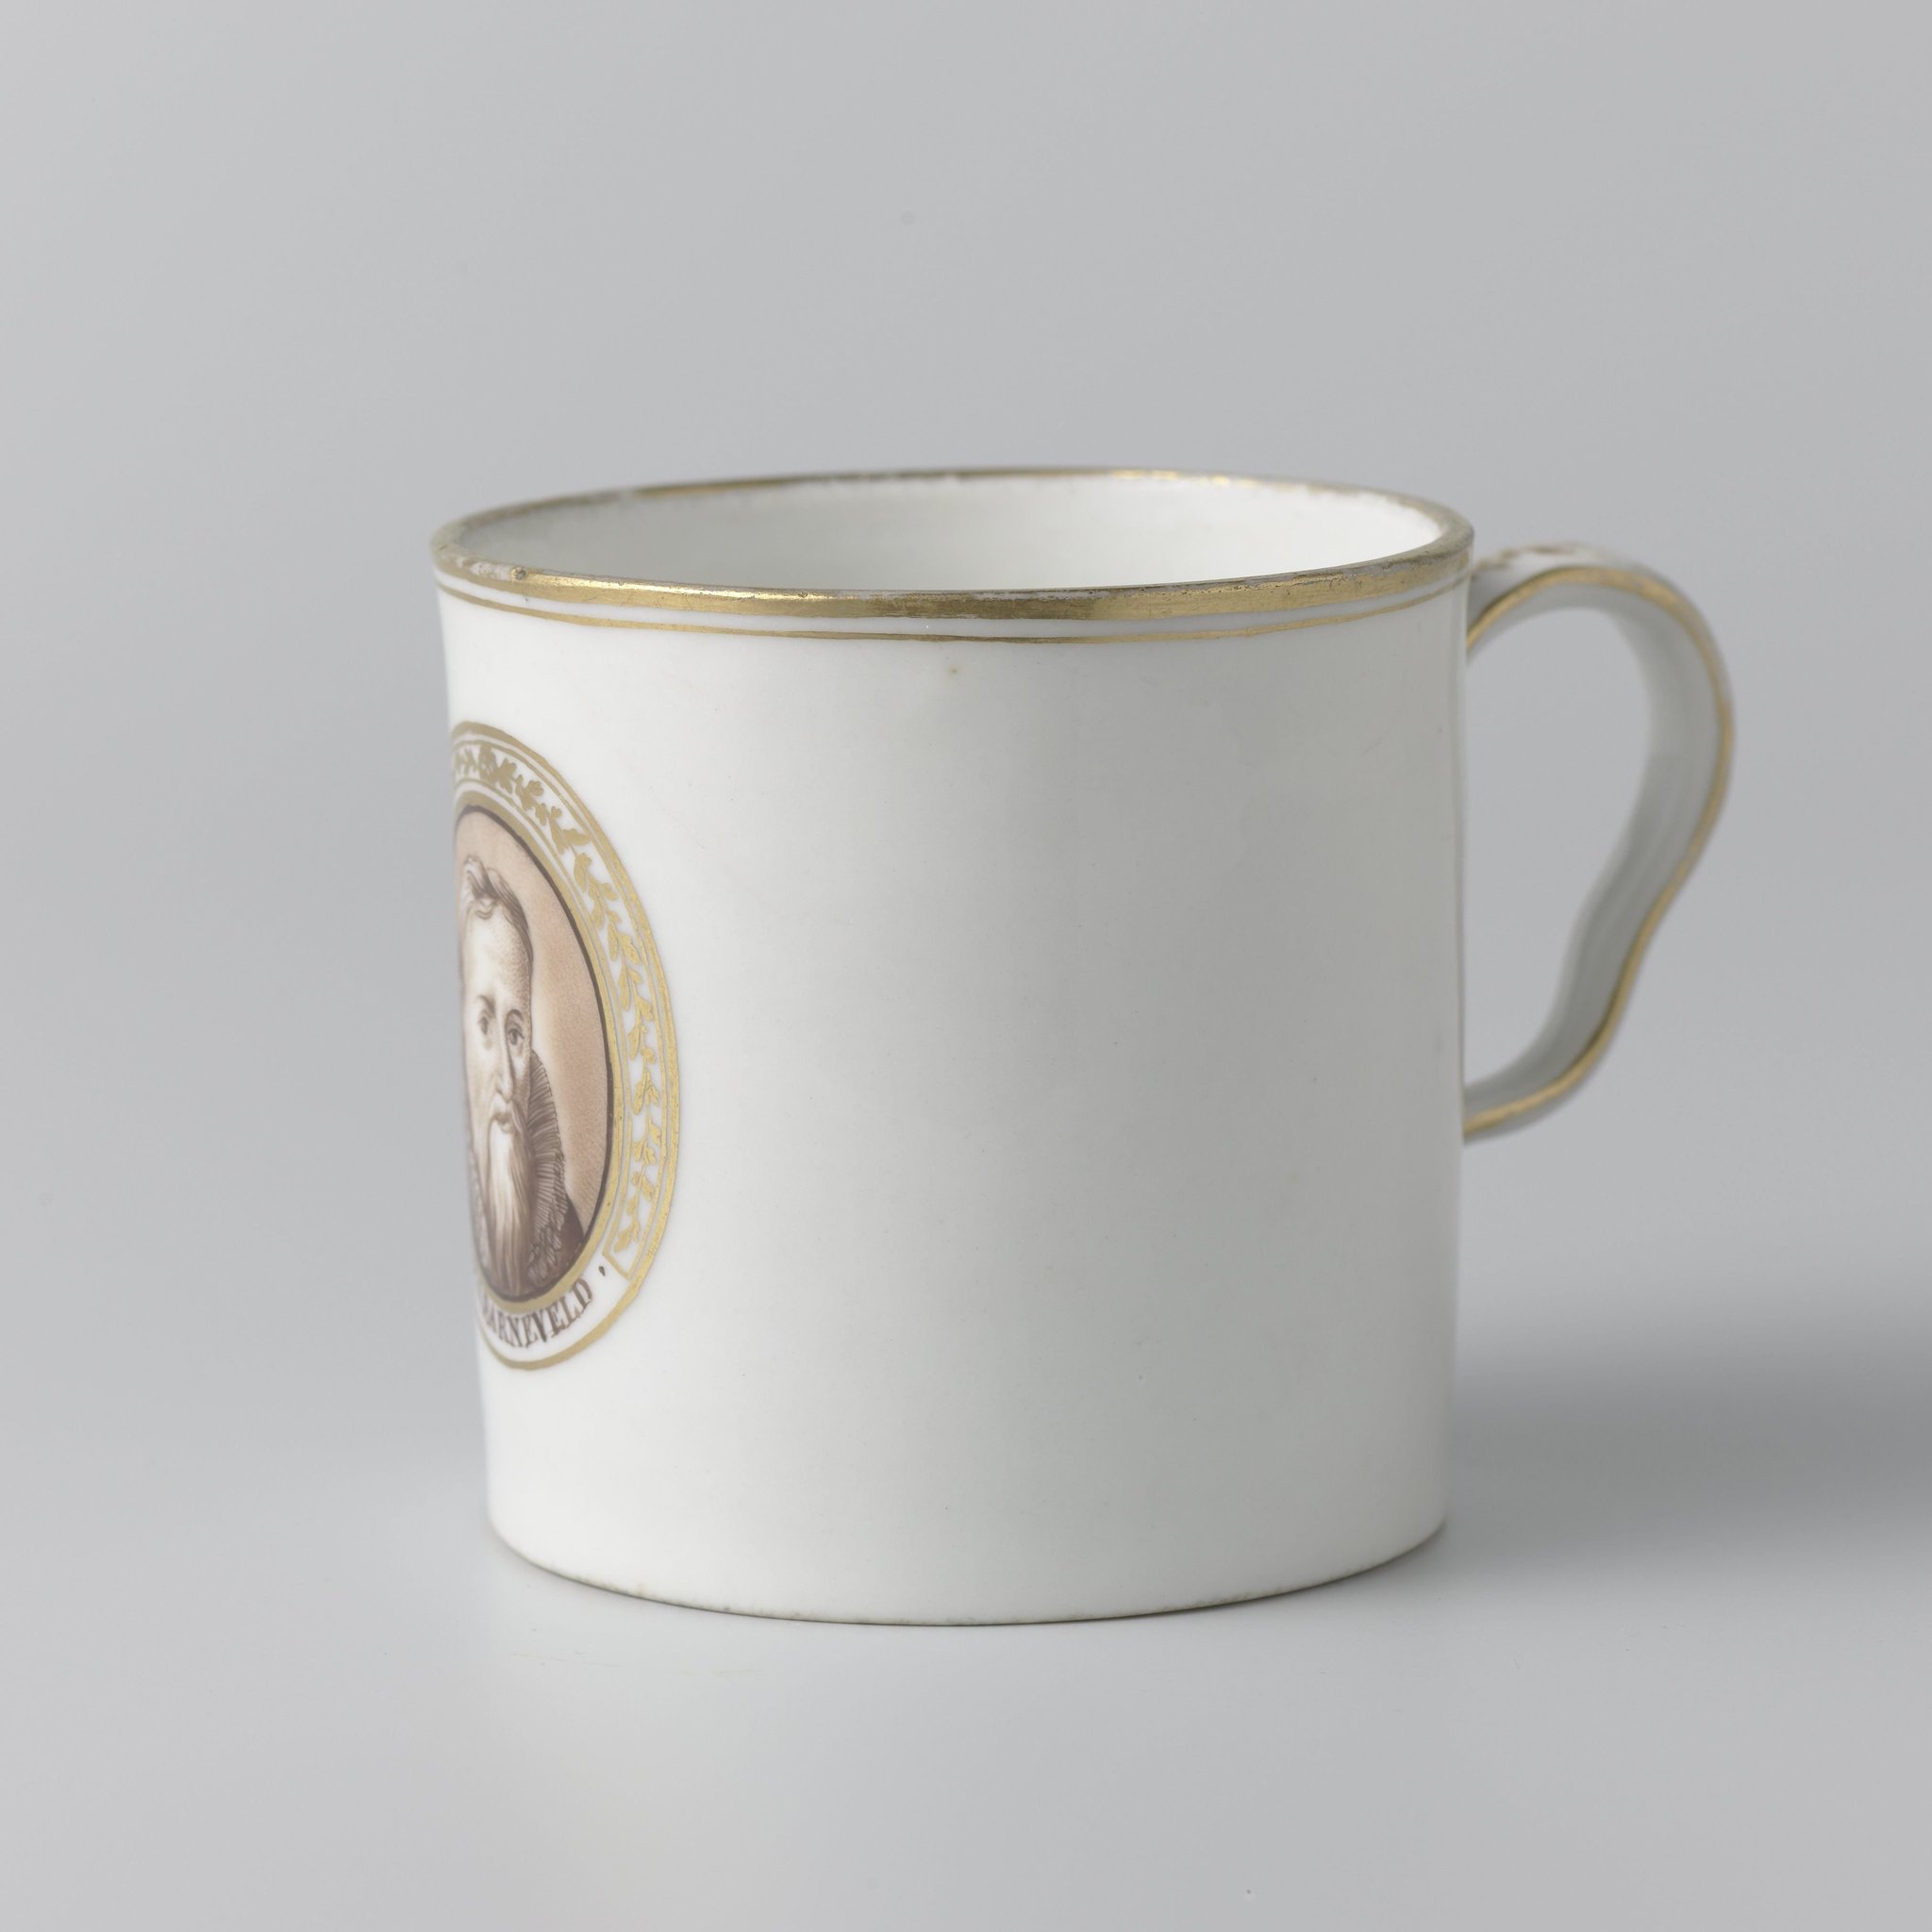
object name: cup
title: Cup with the portrait of Johan van Oldenbarnevelt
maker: Anonymous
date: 1794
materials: glaze, gold, paint, porcelain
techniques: firing, forming, gilding, turning, vitrification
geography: schwarzburg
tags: the hague, johan van oldenbarnevelt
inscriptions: inscription: ‘OLDENBARNEVELD.’, mark: ‘103-N/ 14’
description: Kop van porselein, beschilderd op het glazuur in sepia en goud. Op de buitenwand een medaillon met een portret. Een band met een bladrank en het opschrift 'OLDENBARNEVELD.' om het medaillon. Gouden rand en een bladrank op het oor. Gemerkt op de onderzijde met 103-N en 5.